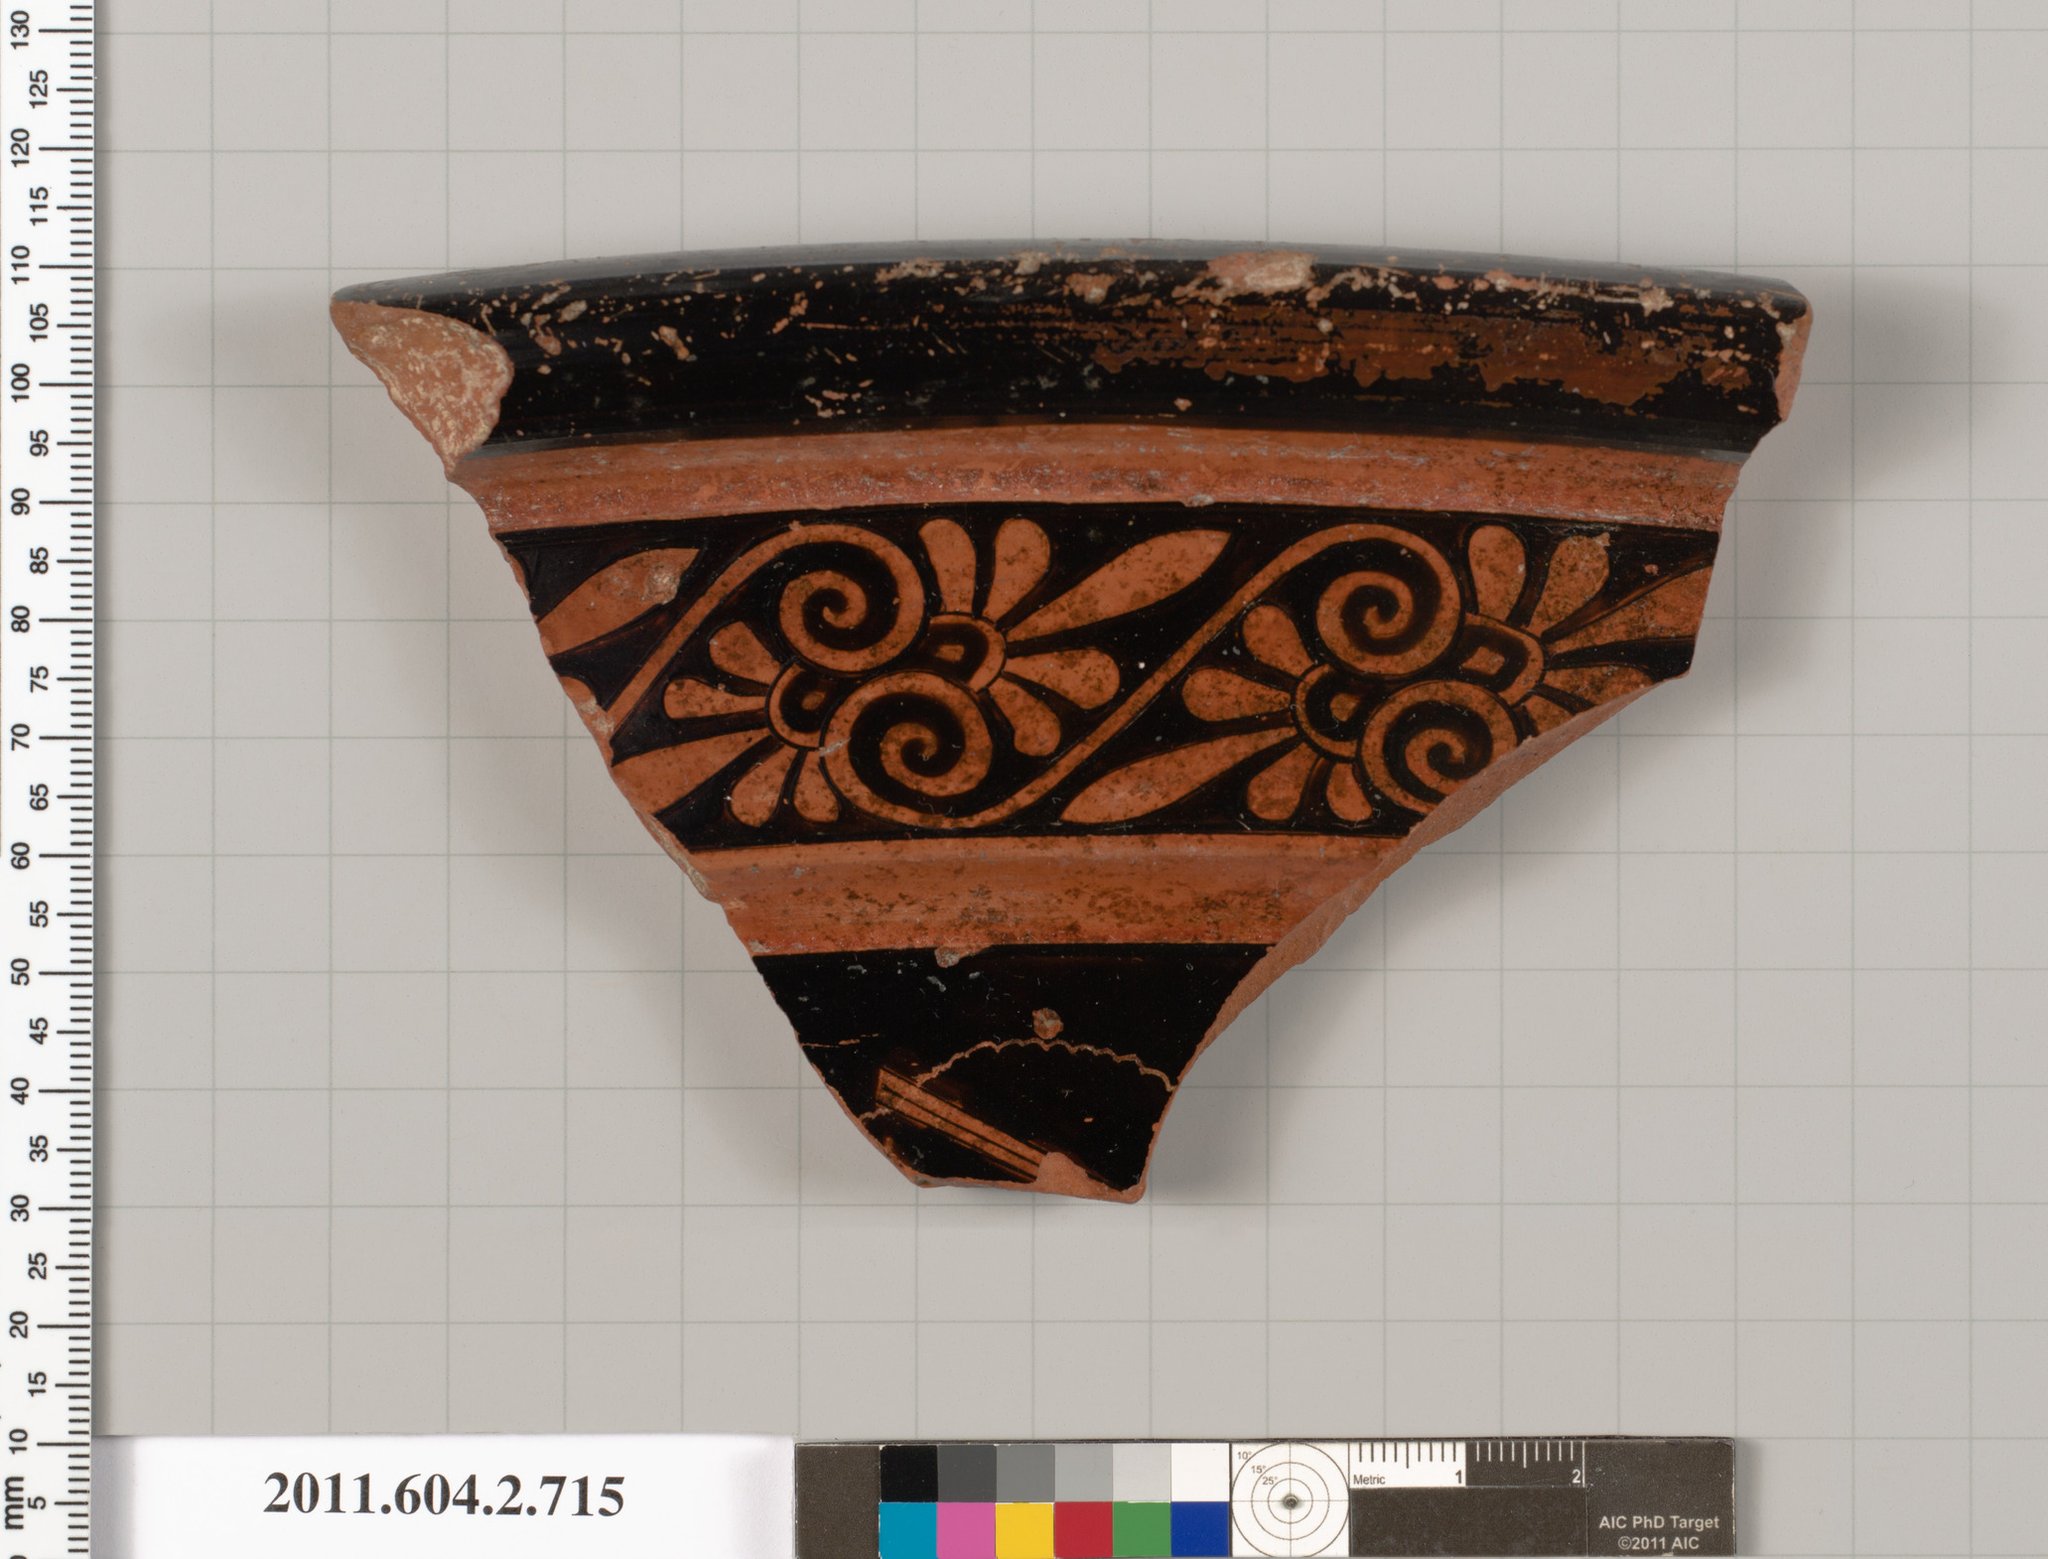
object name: calyx krater fragment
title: Terracotta fragment of a calyx-krater (bowl for mixing wine and water)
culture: greek, attic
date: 500-480 BCE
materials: terracotta